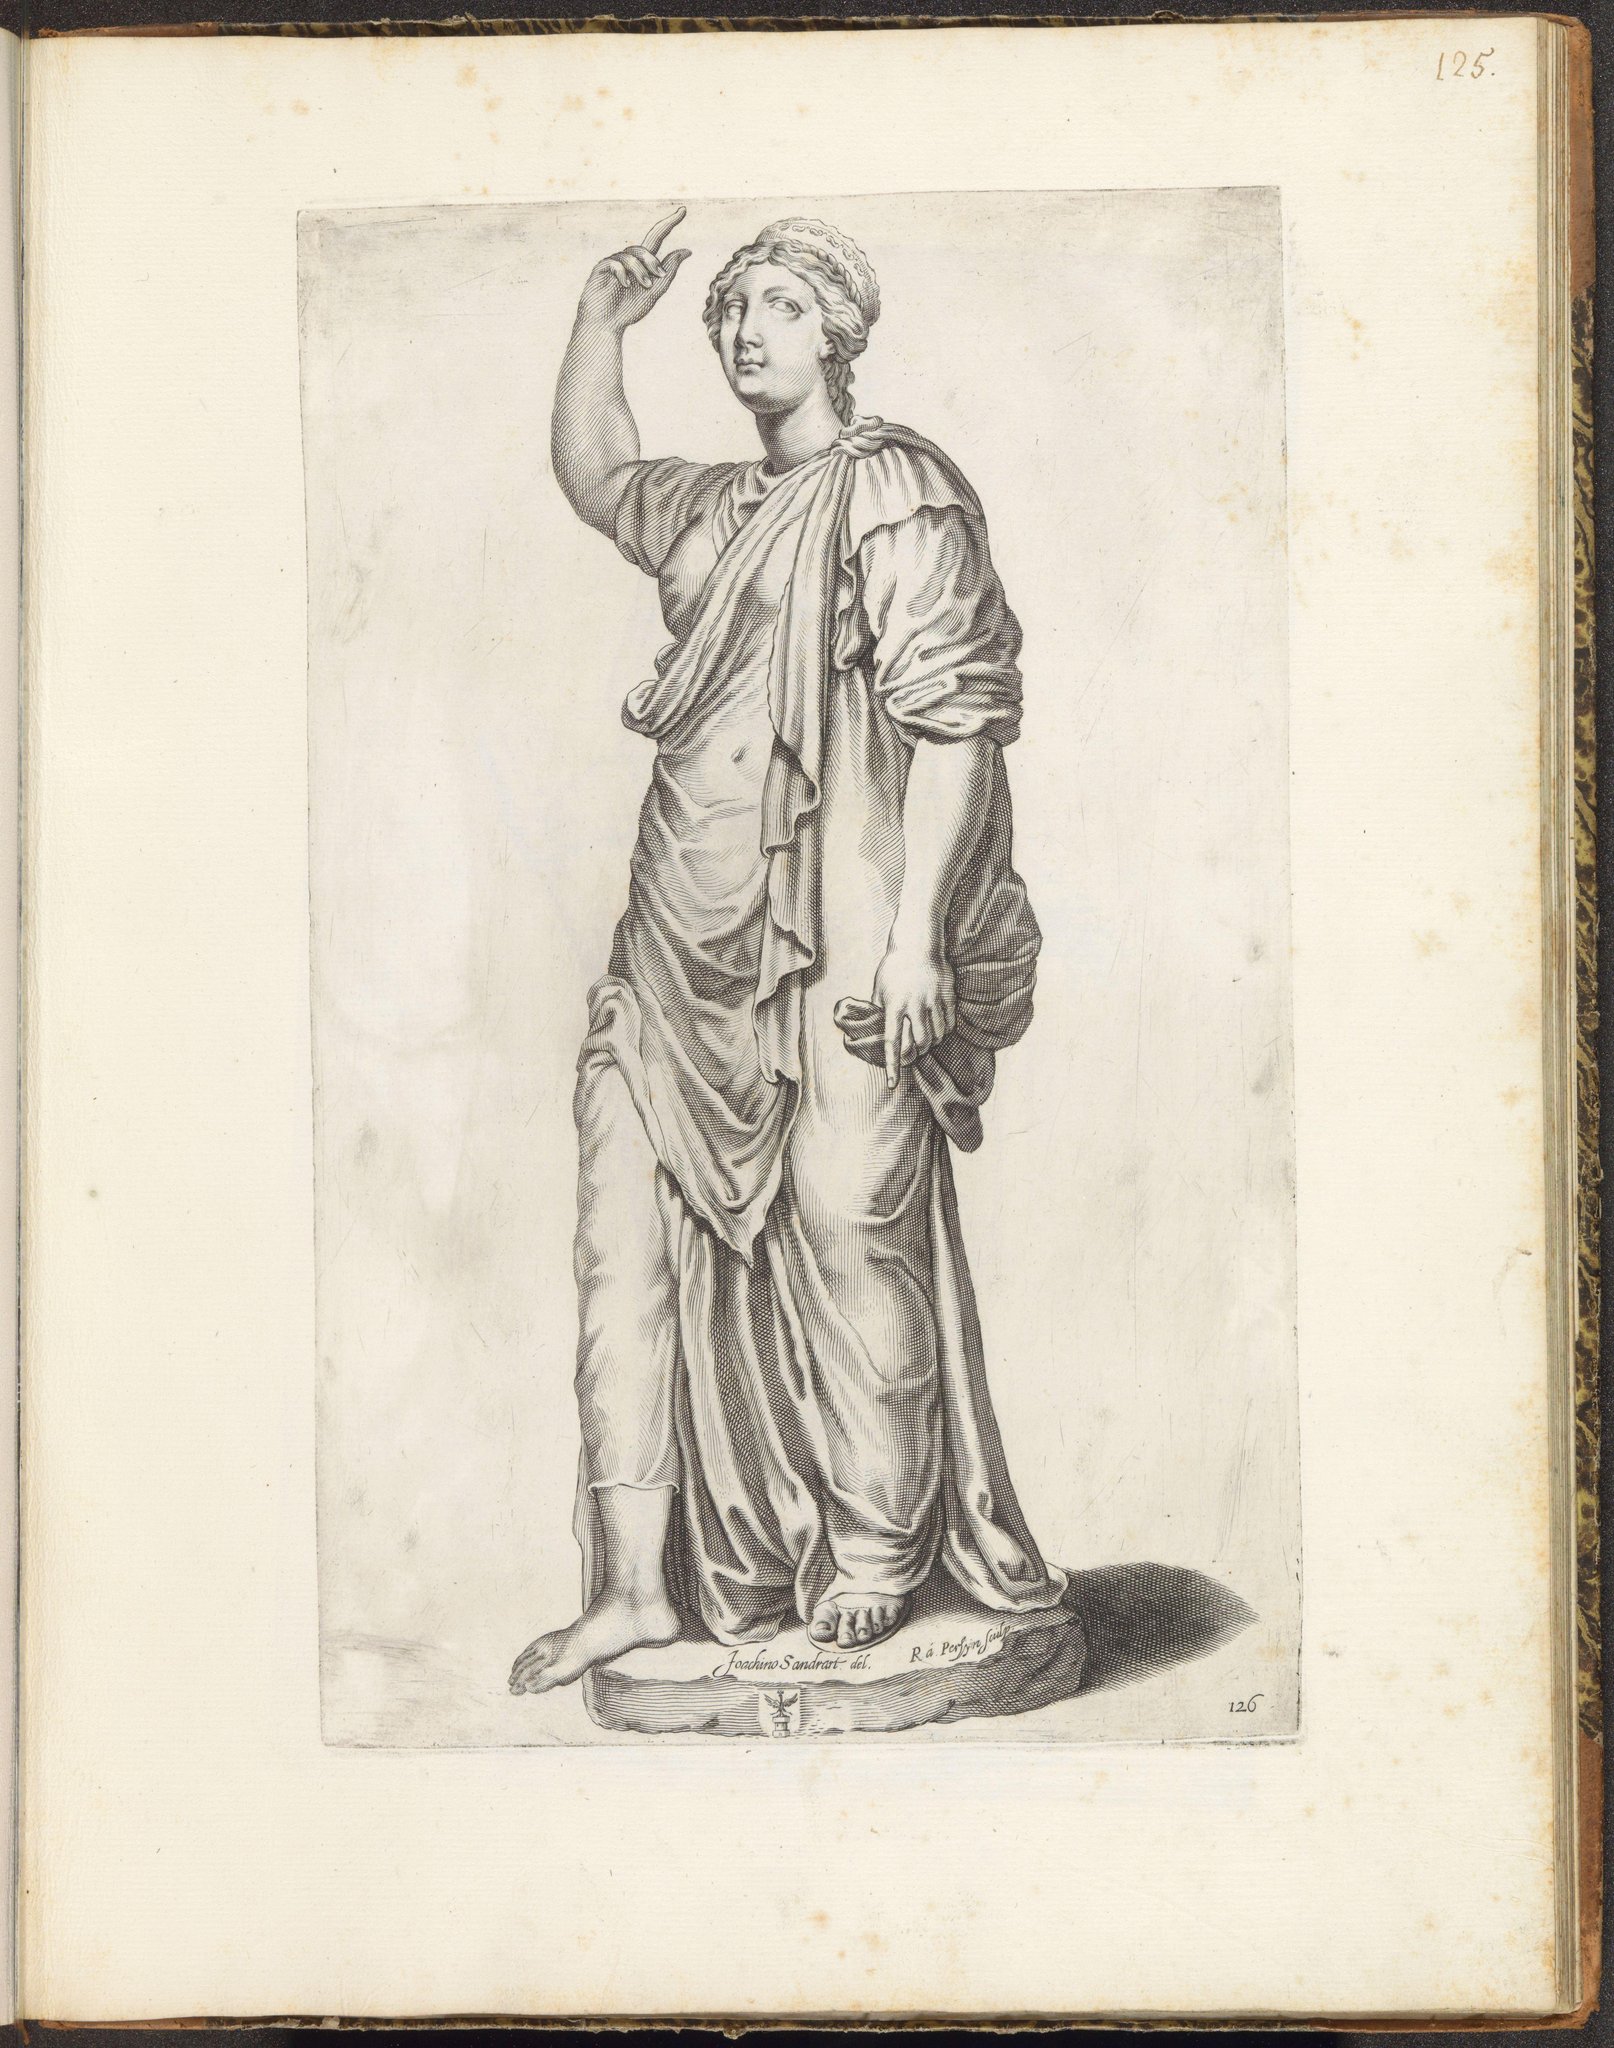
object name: print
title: Galleria Giustiniana del Marchese Vincenzo Giustiniani I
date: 1636-1647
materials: paper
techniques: engraving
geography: rome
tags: piece of sculpture, reproduction of a piece of sculpture, female persons from classical history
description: Standbeeld van een vrouw, in klassiek gewaad, met opgeheven arm. Midden onder op de basis het wapenschild van Vincenzo Giustiniani. Prent maakt deel uit van een album met een serie prenten naar de sculpturen in de verzameling in de Galleria Giustiniani te Rome.